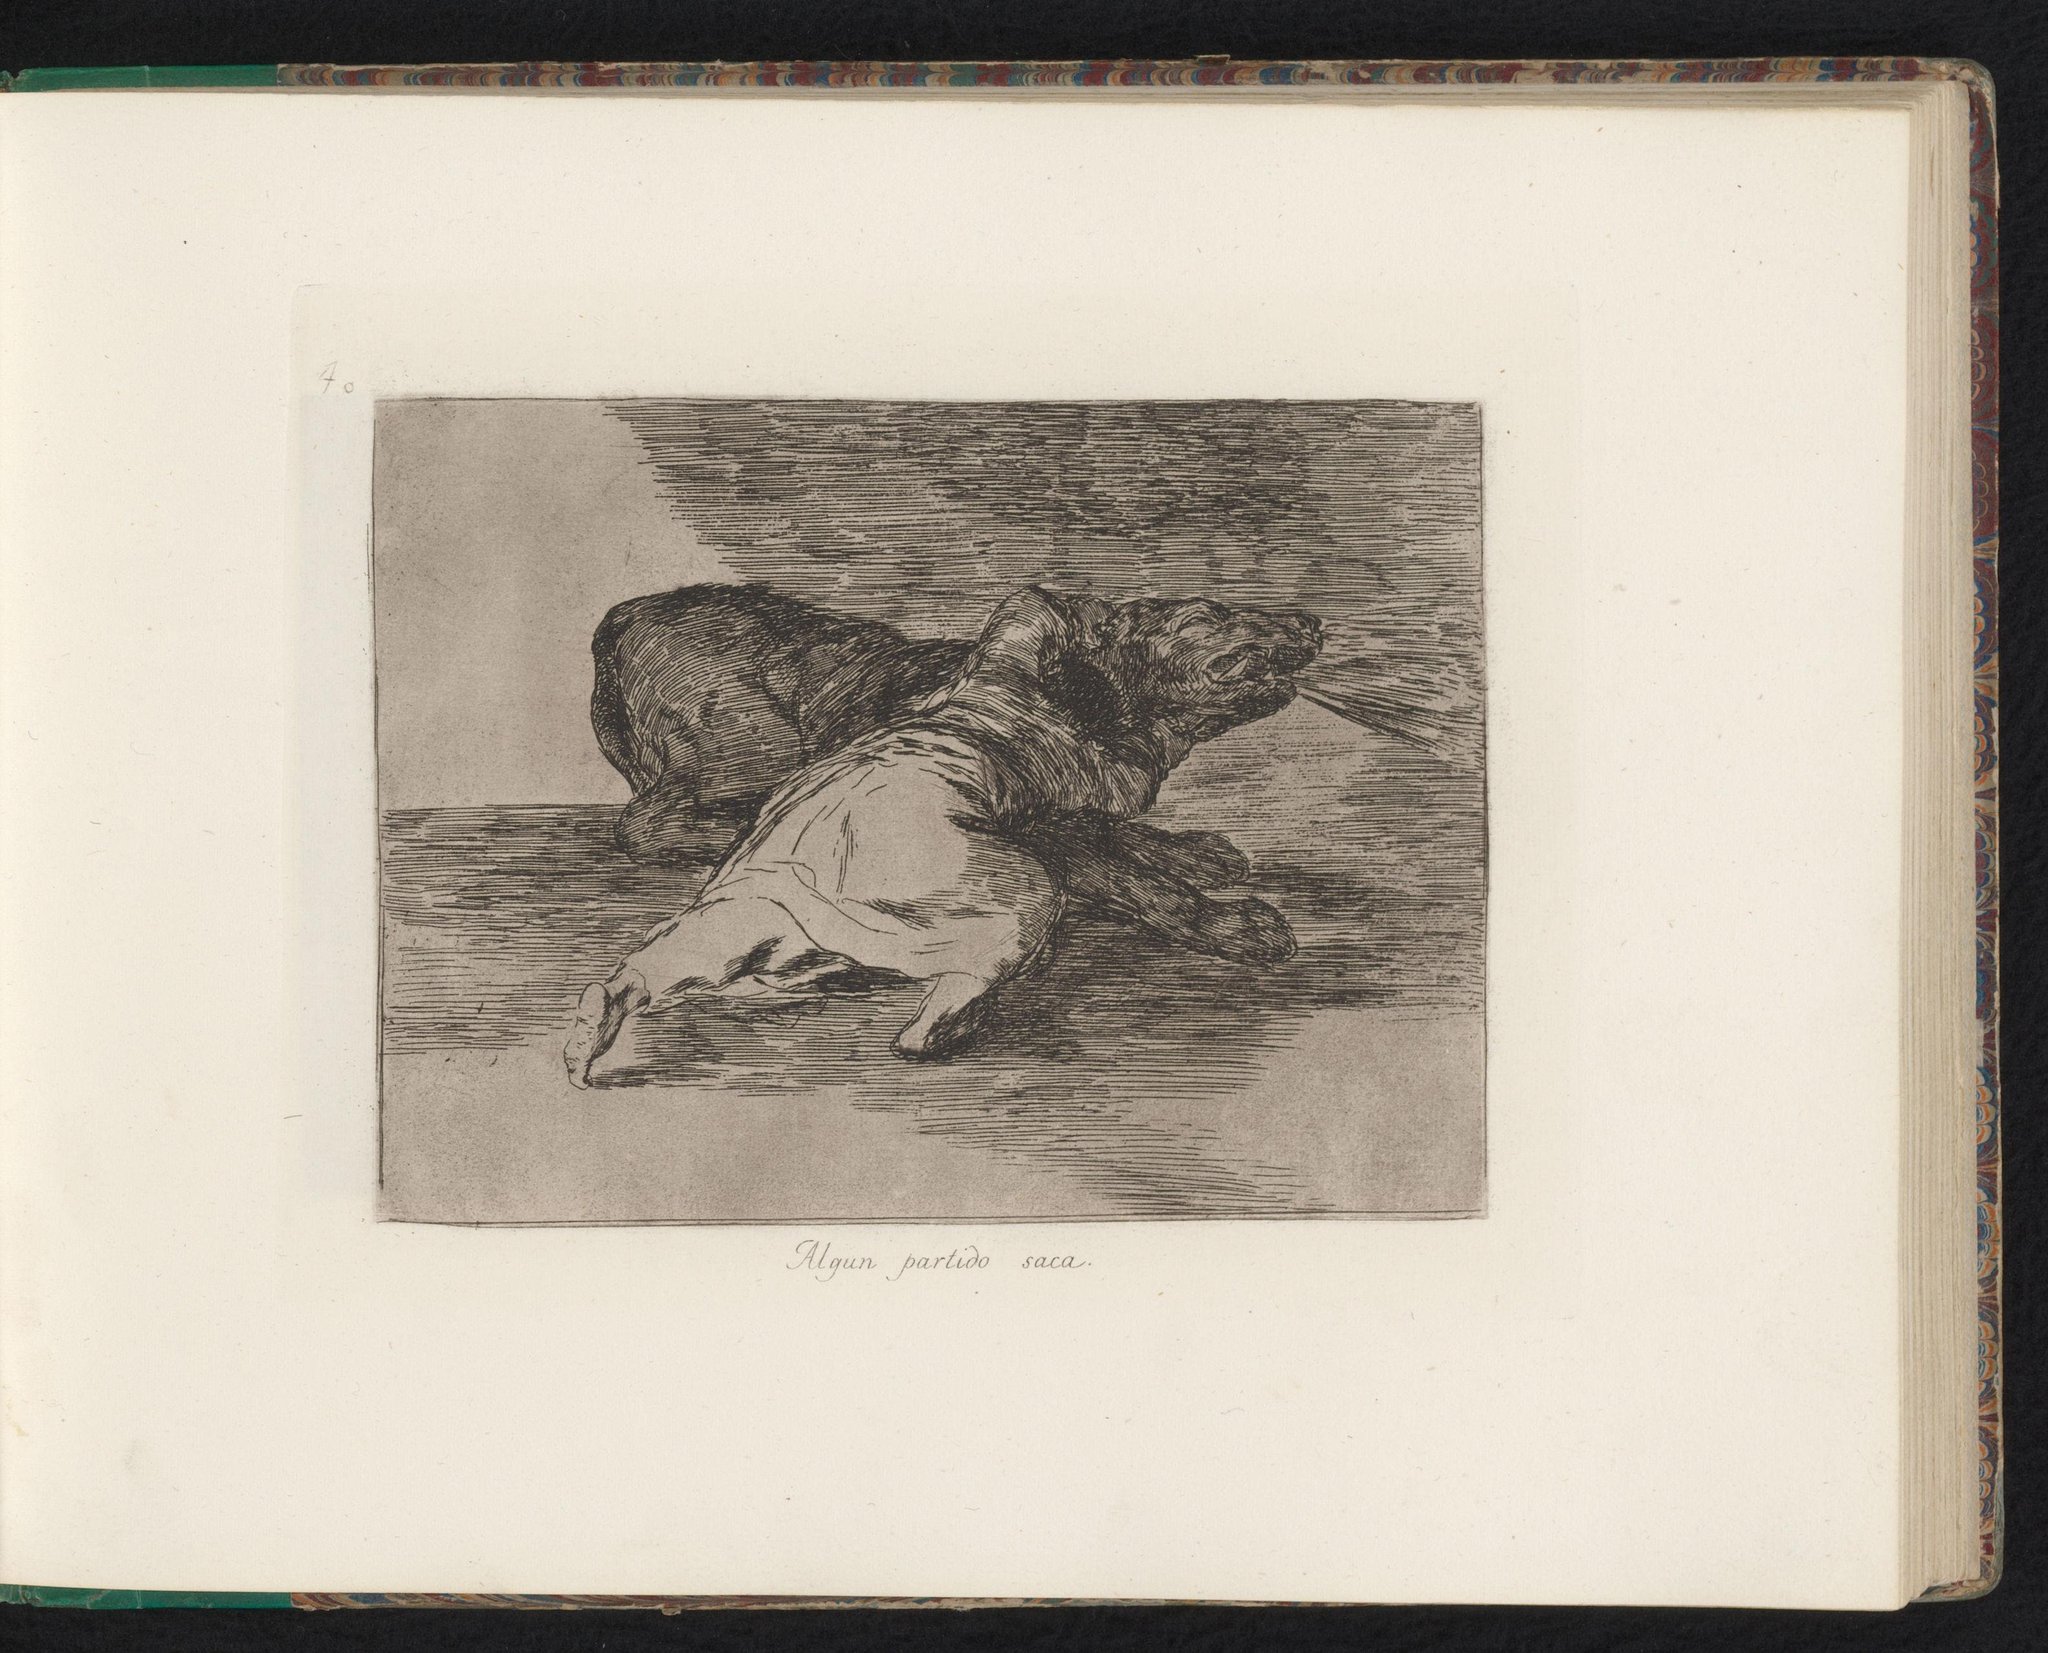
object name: print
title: Algun partido saca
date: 1810-1820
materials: paper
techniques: drypoint, engraving, etching, intaglio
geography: madrid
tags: monsters larger than normal, horrors of war, spain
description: Deze prent maakt deel uit van een album.